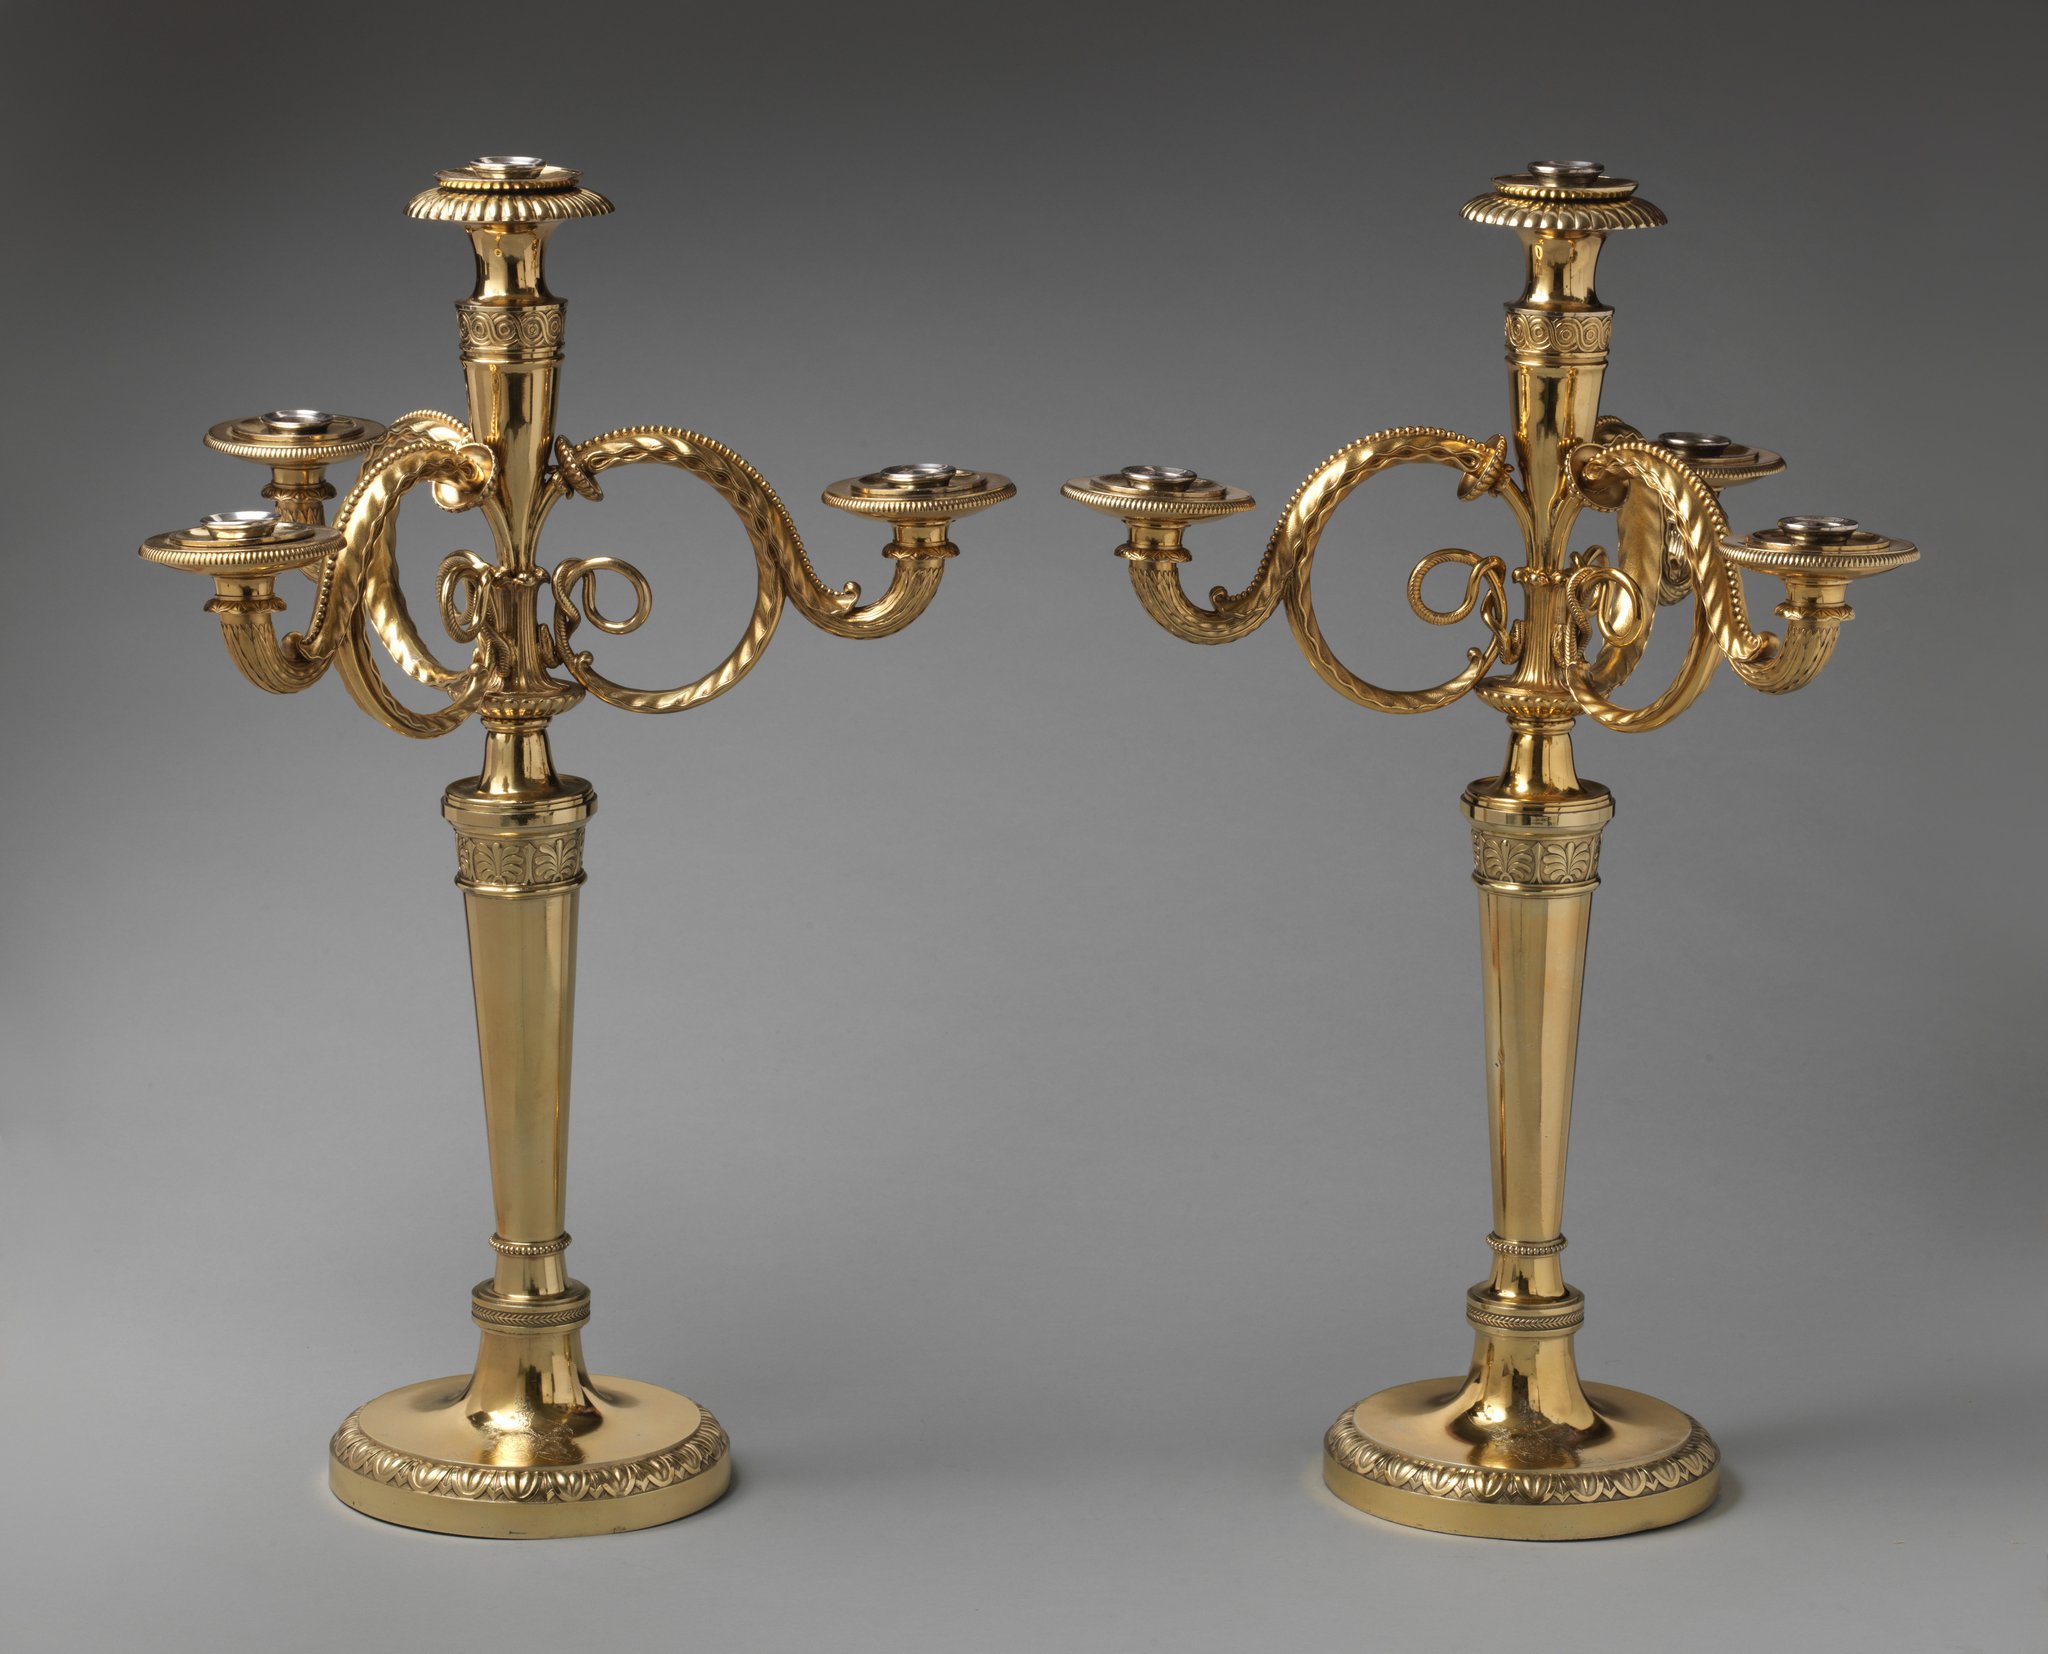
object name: candelabrum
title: Pair of candelabra bearing the arms of the Duke of York (1763–1827)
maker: henri auguste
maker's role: maker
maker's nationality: french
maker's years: 1759-1816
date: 1788-1789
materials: silver